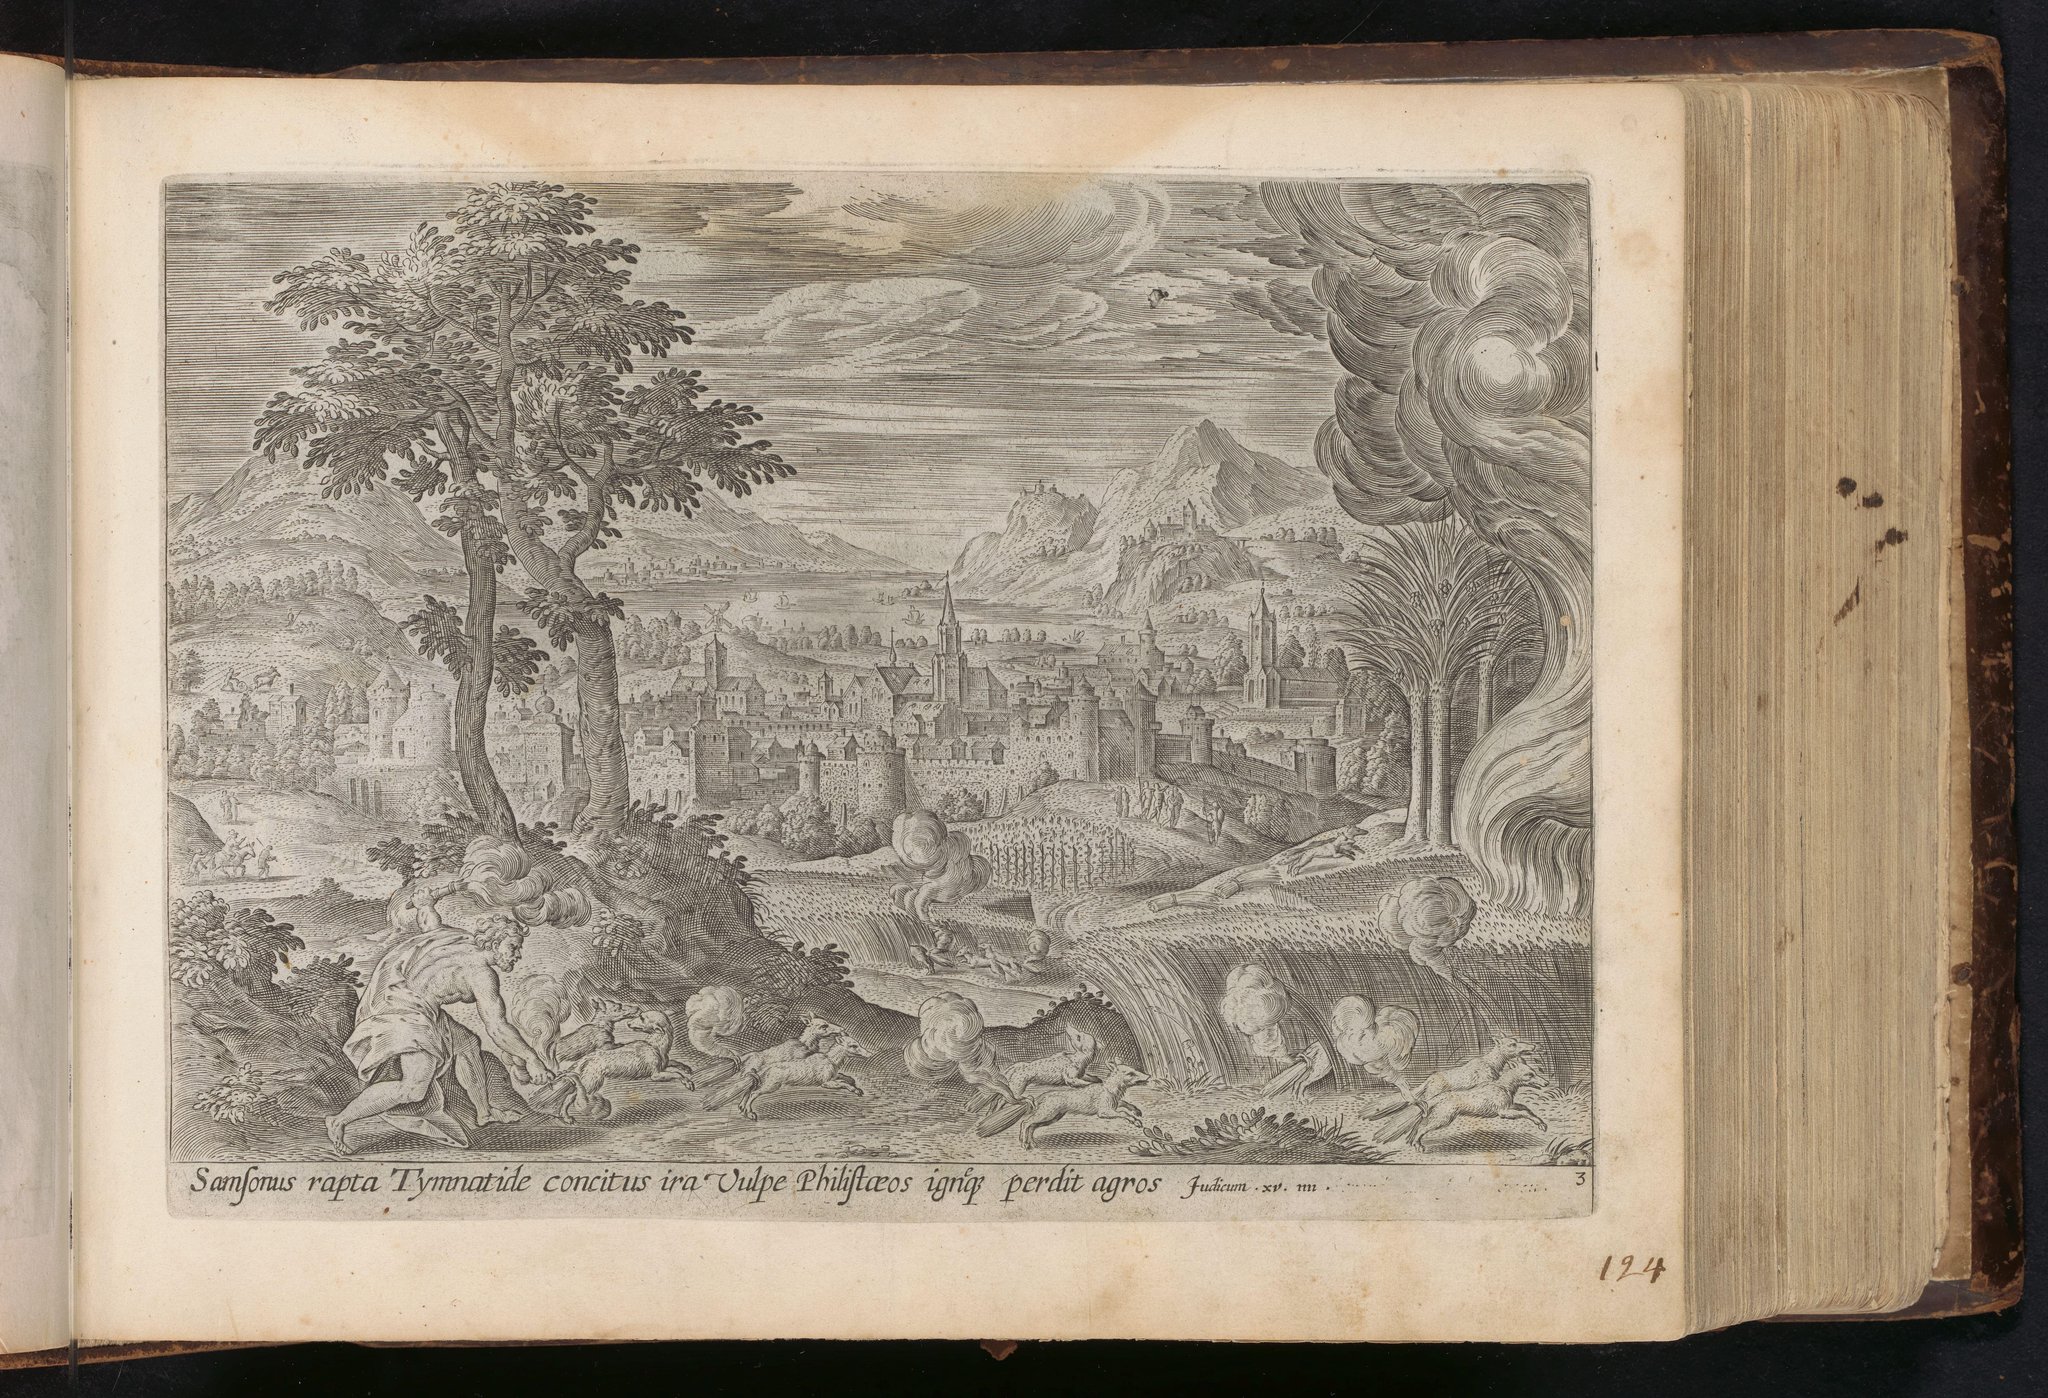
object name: print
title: Simson steekt de korenvelden van de Filistijnen in brand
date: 1579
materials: paper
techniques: engraving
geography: amsterdam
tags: samson ties three hundred foxes two by two by their tails with a fire-brand in between; with the torches on fire he lets them go into the cornfields of the philistines which are set aflame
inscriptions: number: ‘124’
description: Simson steekt de korenvelden van de Filistijnen in brand door vossen twee aan twee met de staarten aan elkaar te binden en een brandende fakkel ertussen te hangen. Simson stuurt de vossen het korenveld in. Onder de voorstelling een verwijzing in het Latijn naar de Bijbeltekst in Ri. 15:4. Deze prent maakt deel uit van een album.